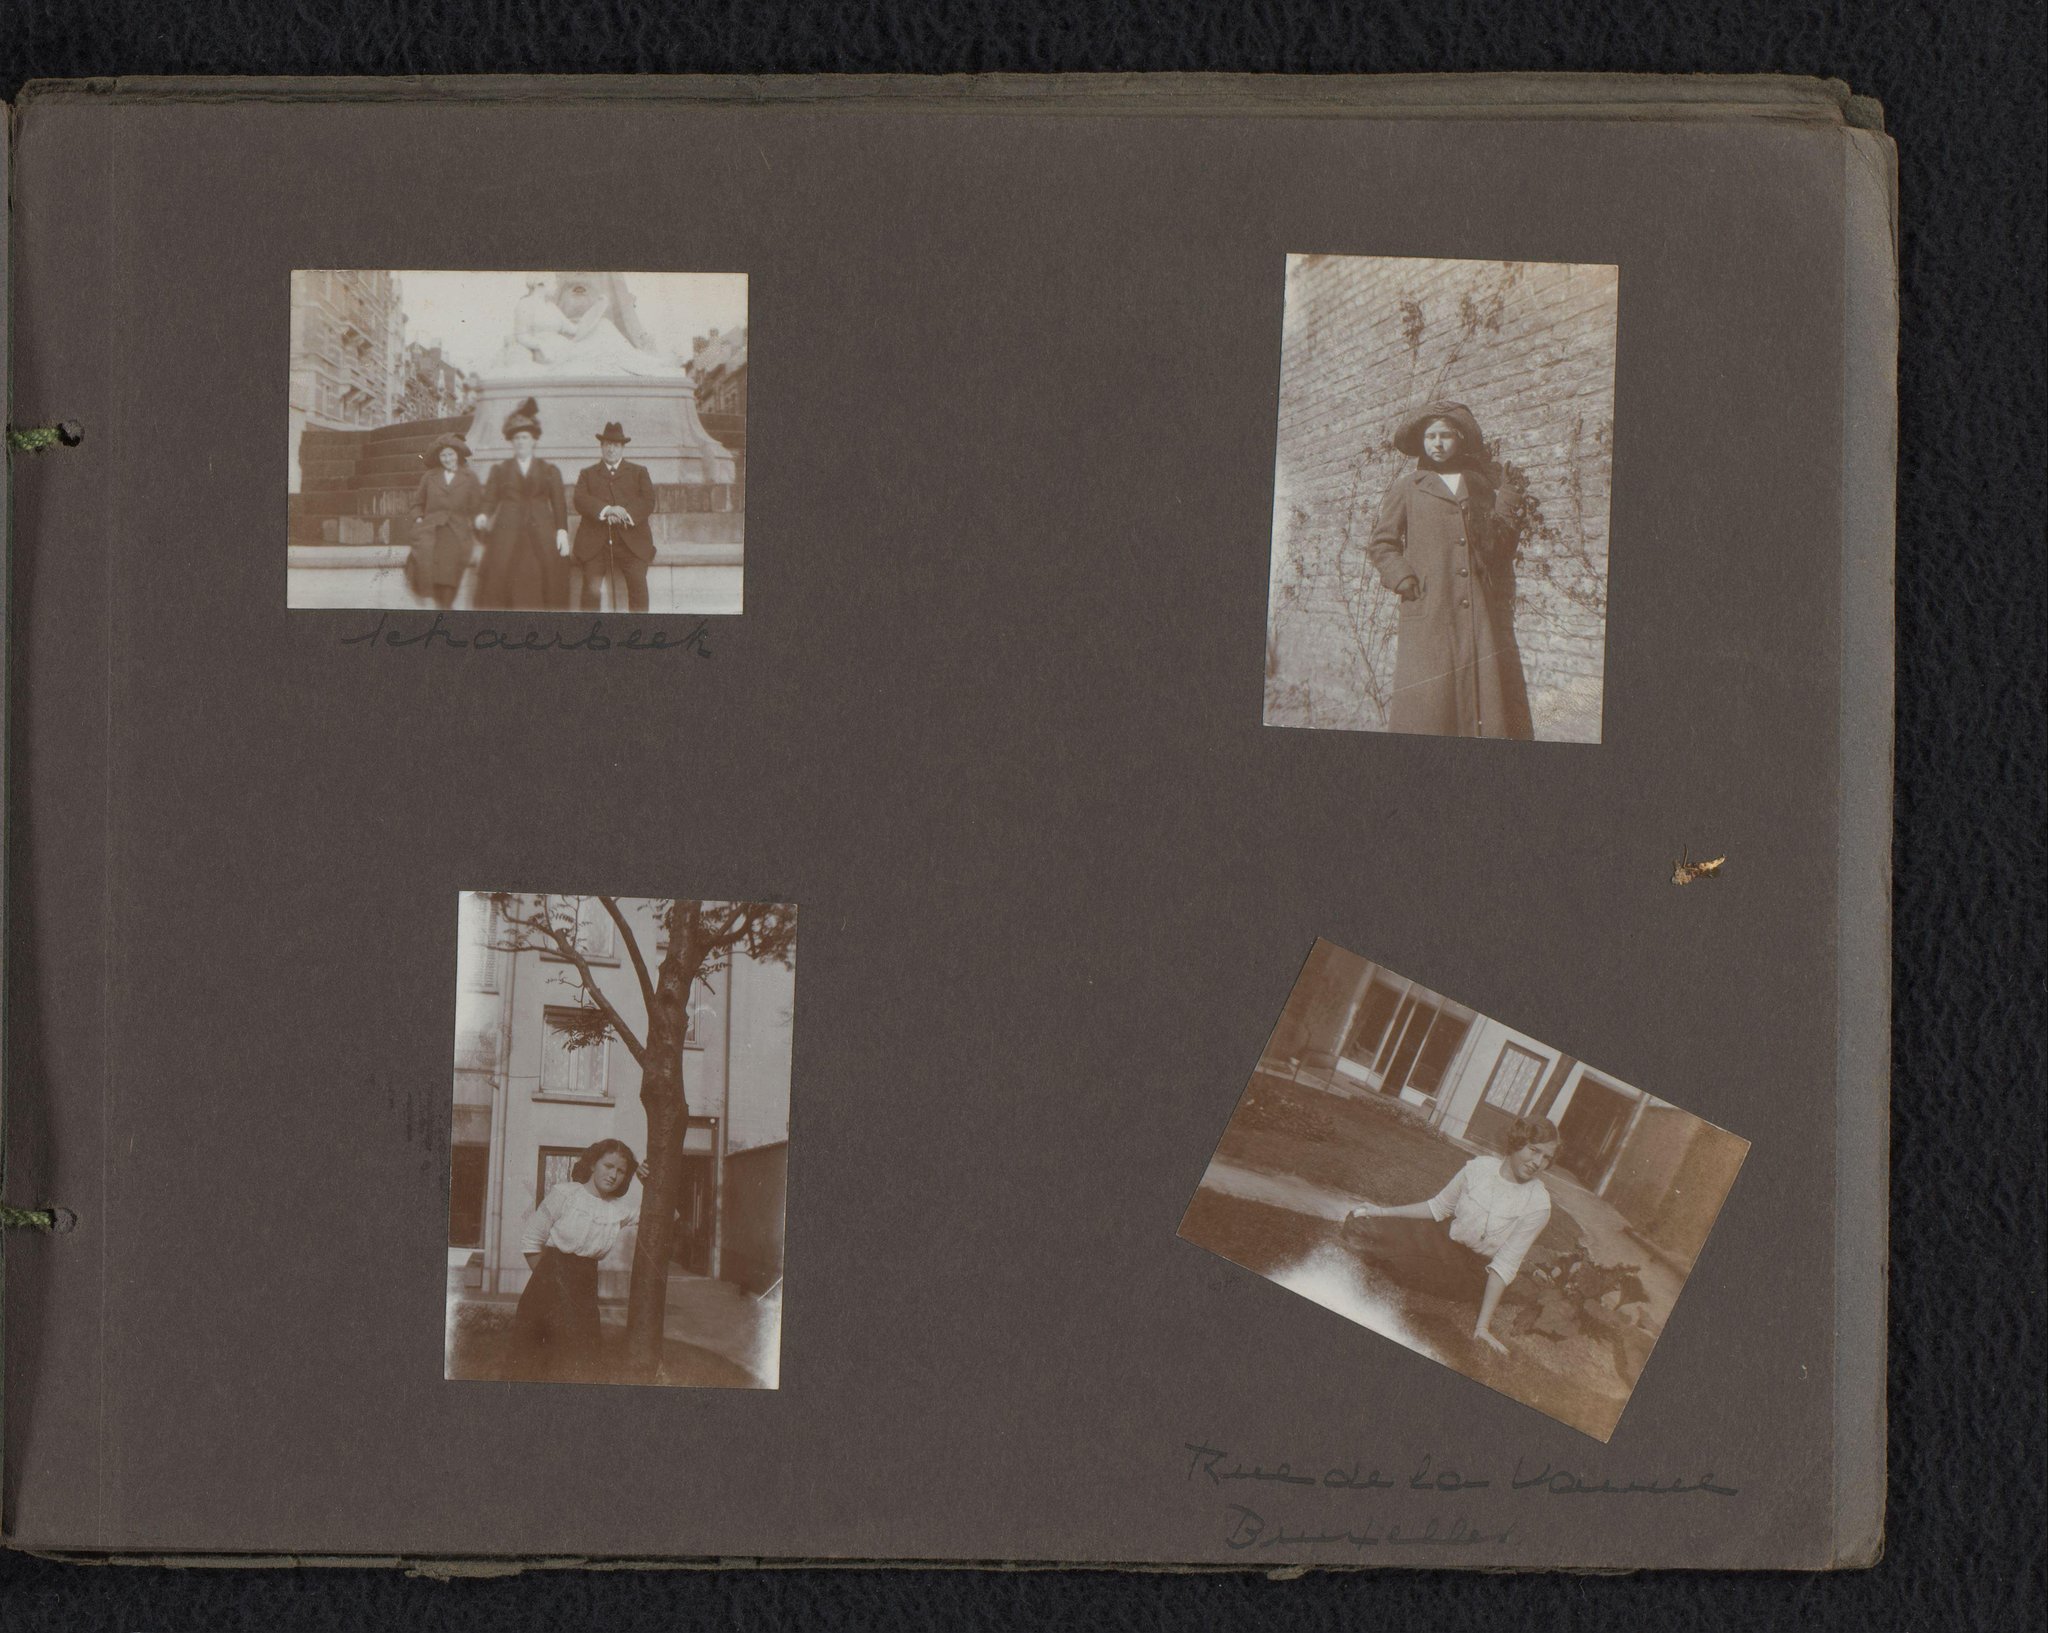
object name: photograph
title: Gezin van Loentje Onnen in Brussel en Schaarbeek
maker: carolina frederika onnen (lien/loen)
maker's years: 1896-1983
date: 1904-1912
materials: paper, cardboard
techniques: collodion silver print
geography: belgium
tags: family life, brussels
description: Deze foto's zijn onderdeel van een album.